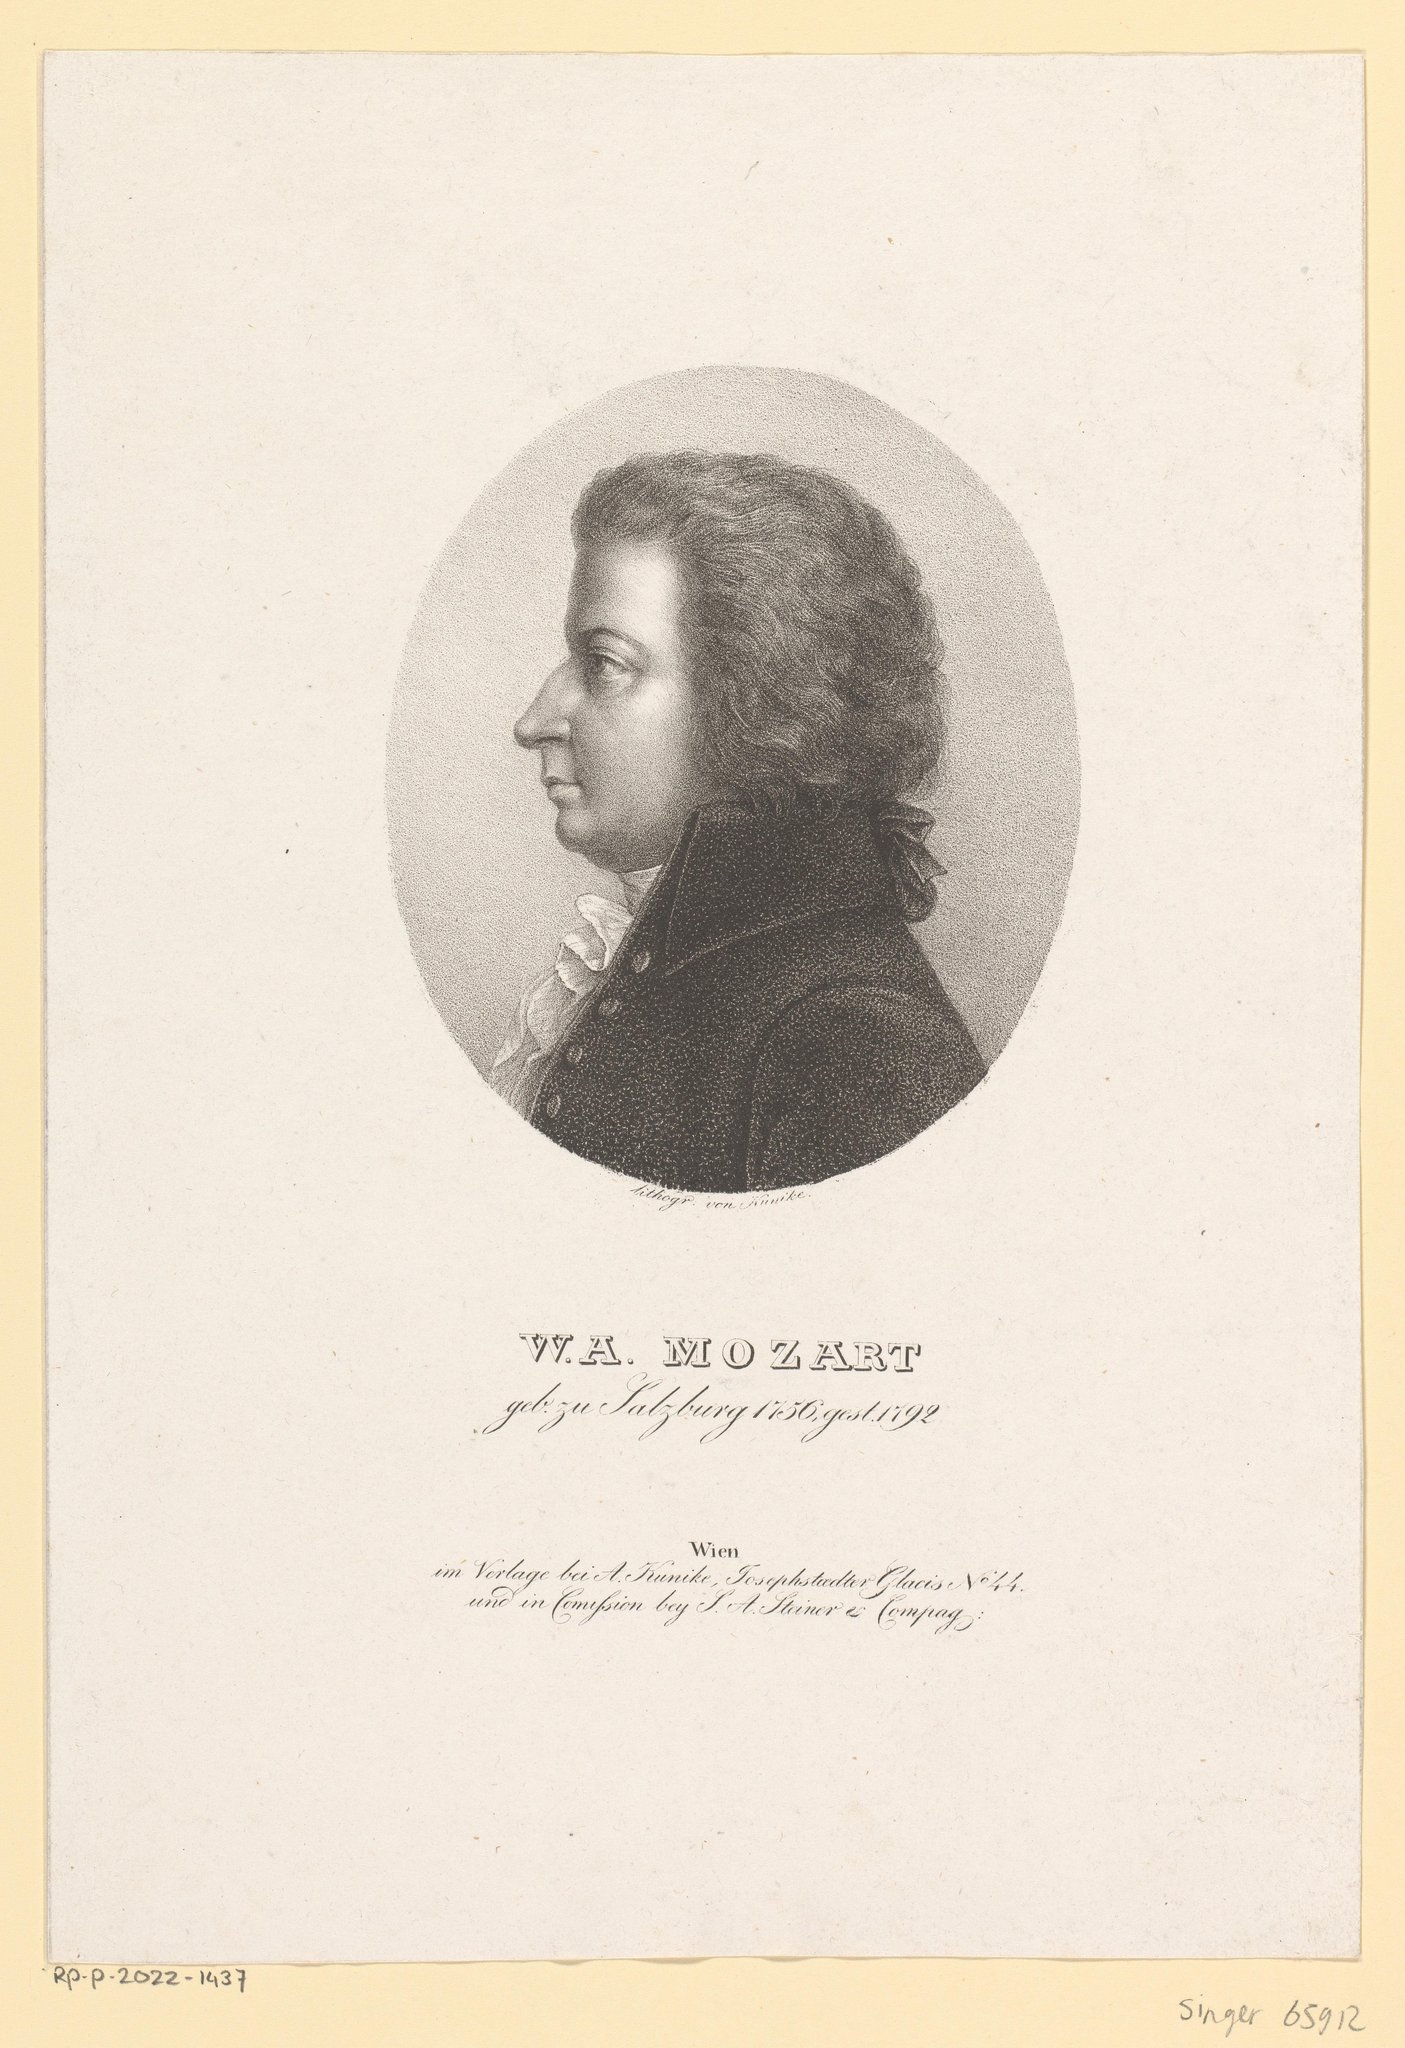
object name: print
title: Portret van Wolfgang Amadeus Mozart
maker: adolph kunike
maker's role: print maker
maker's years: 1777-1838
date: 1792-1838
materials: paper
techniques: lithograph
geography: vienna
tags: historical persons, portrait of composer